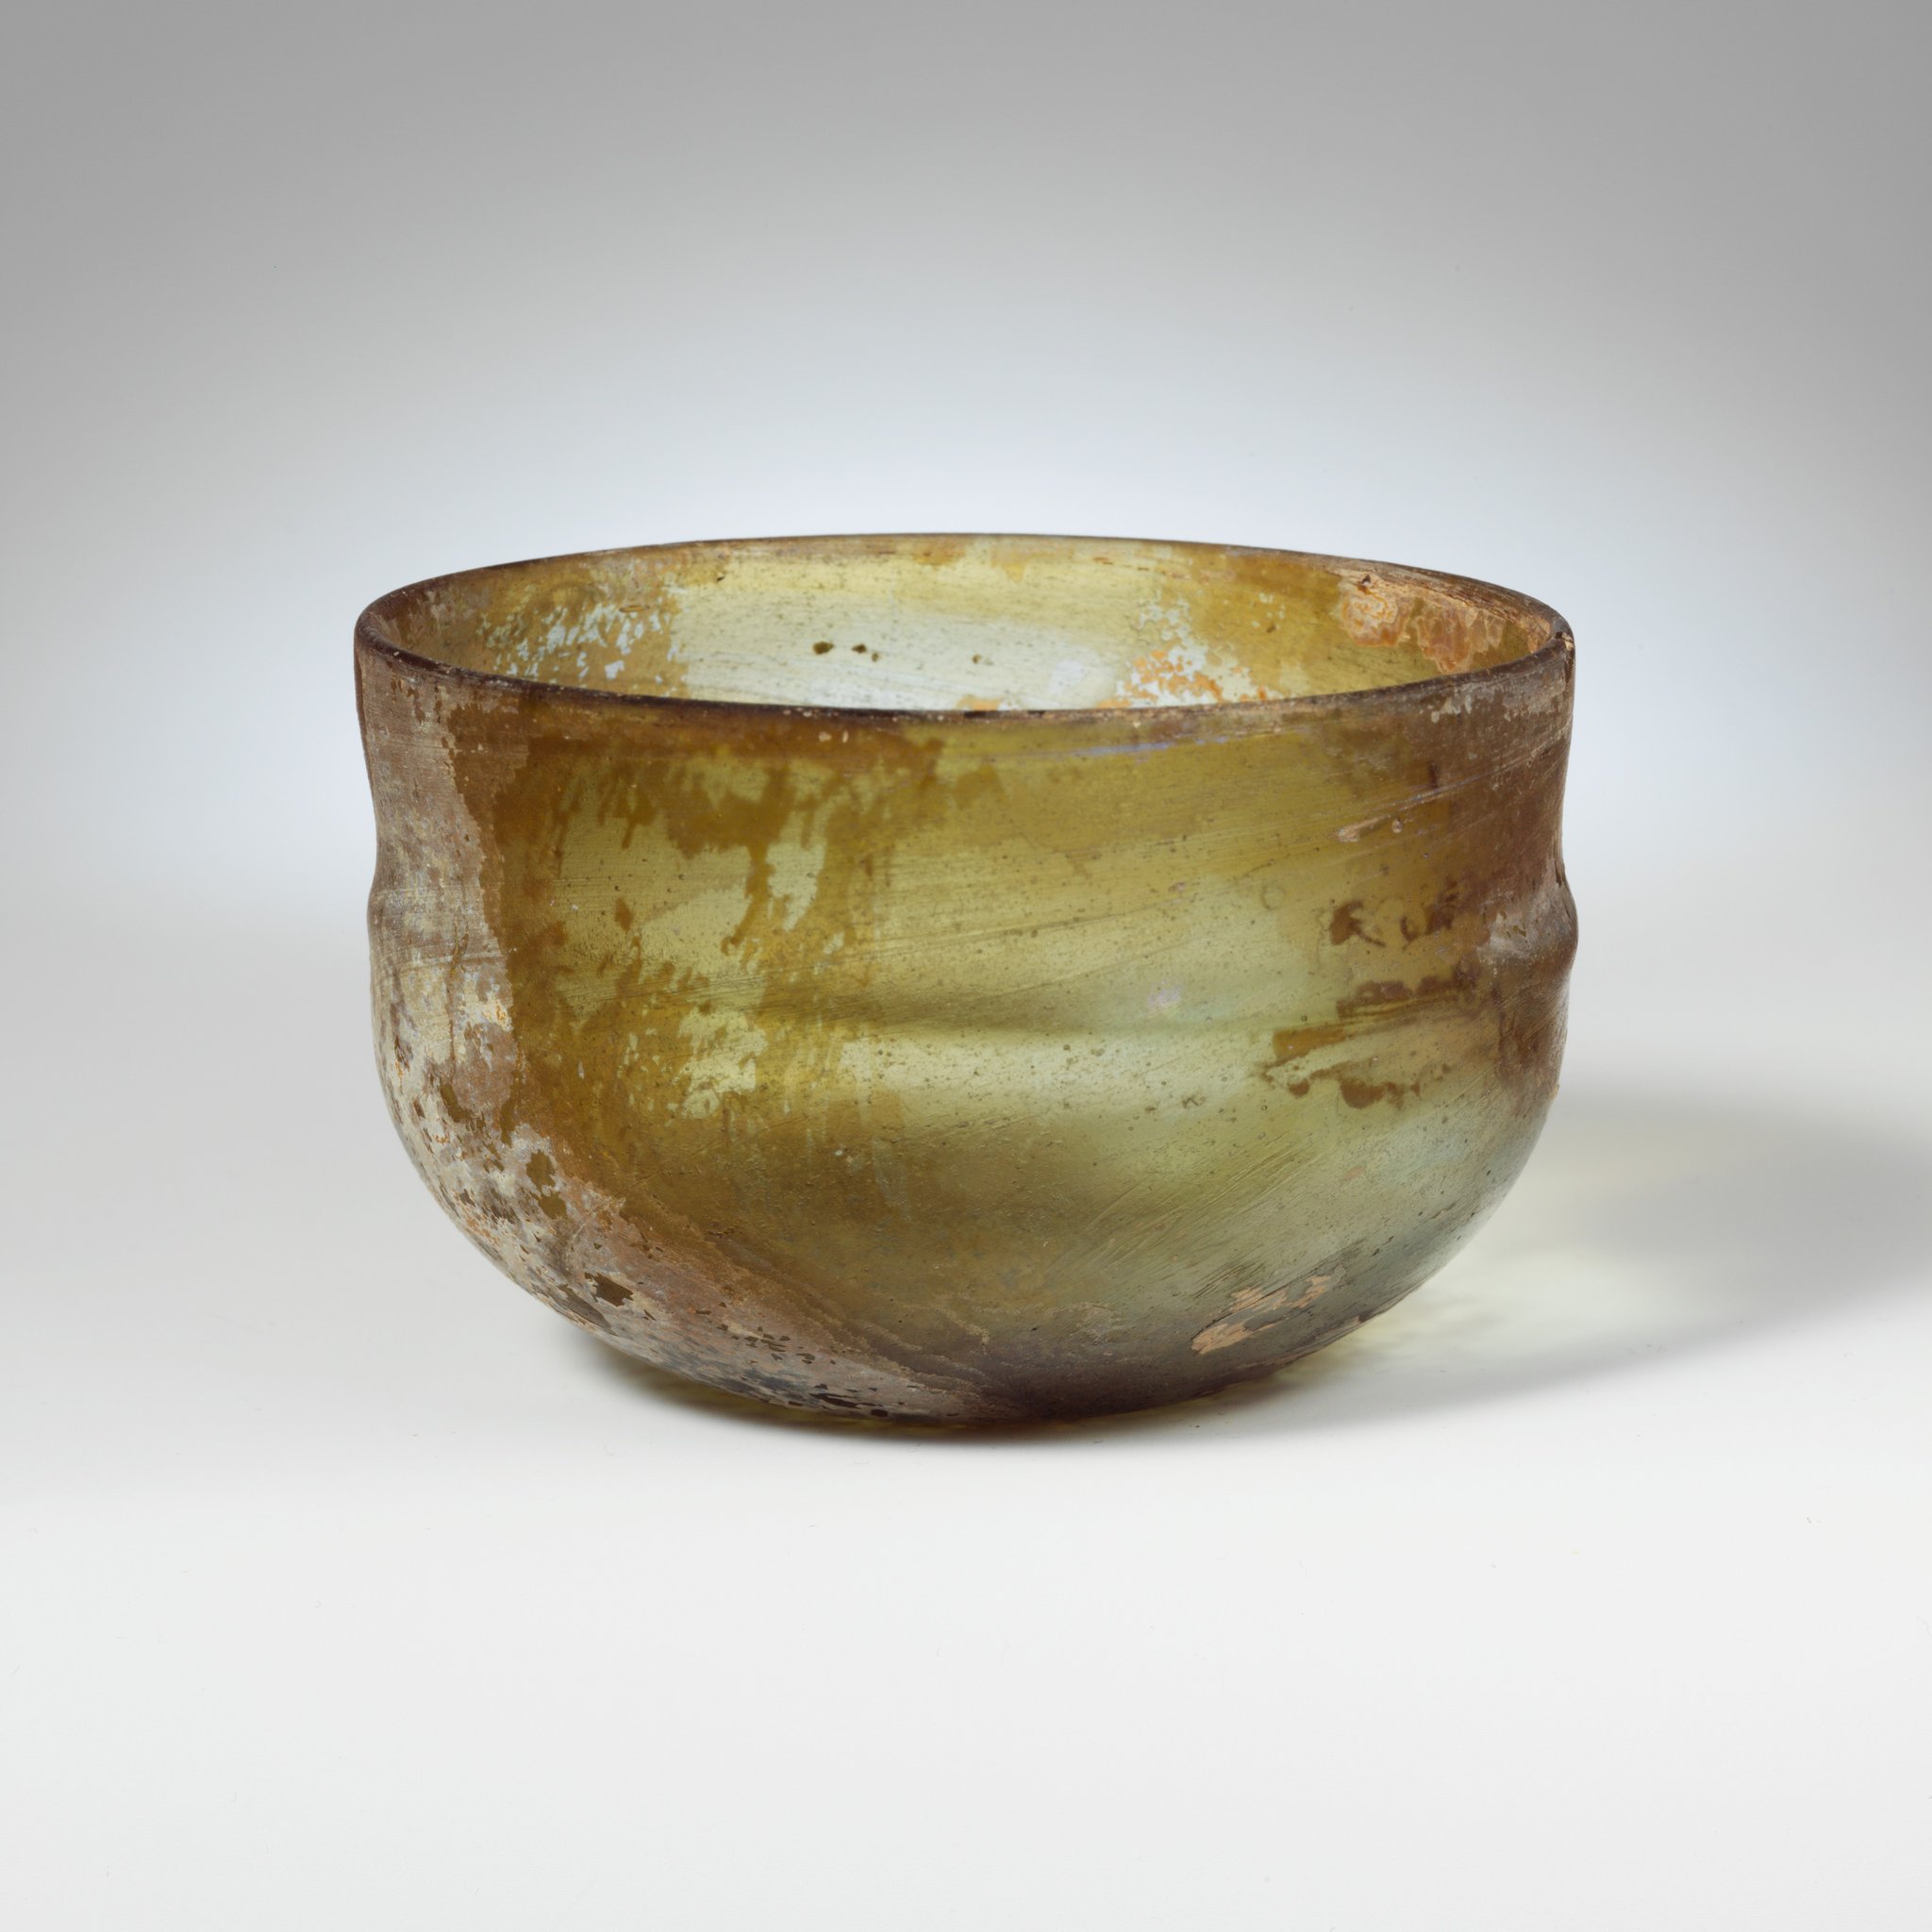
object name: bowl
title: Glass bowl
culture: roman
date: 201-400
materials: glass